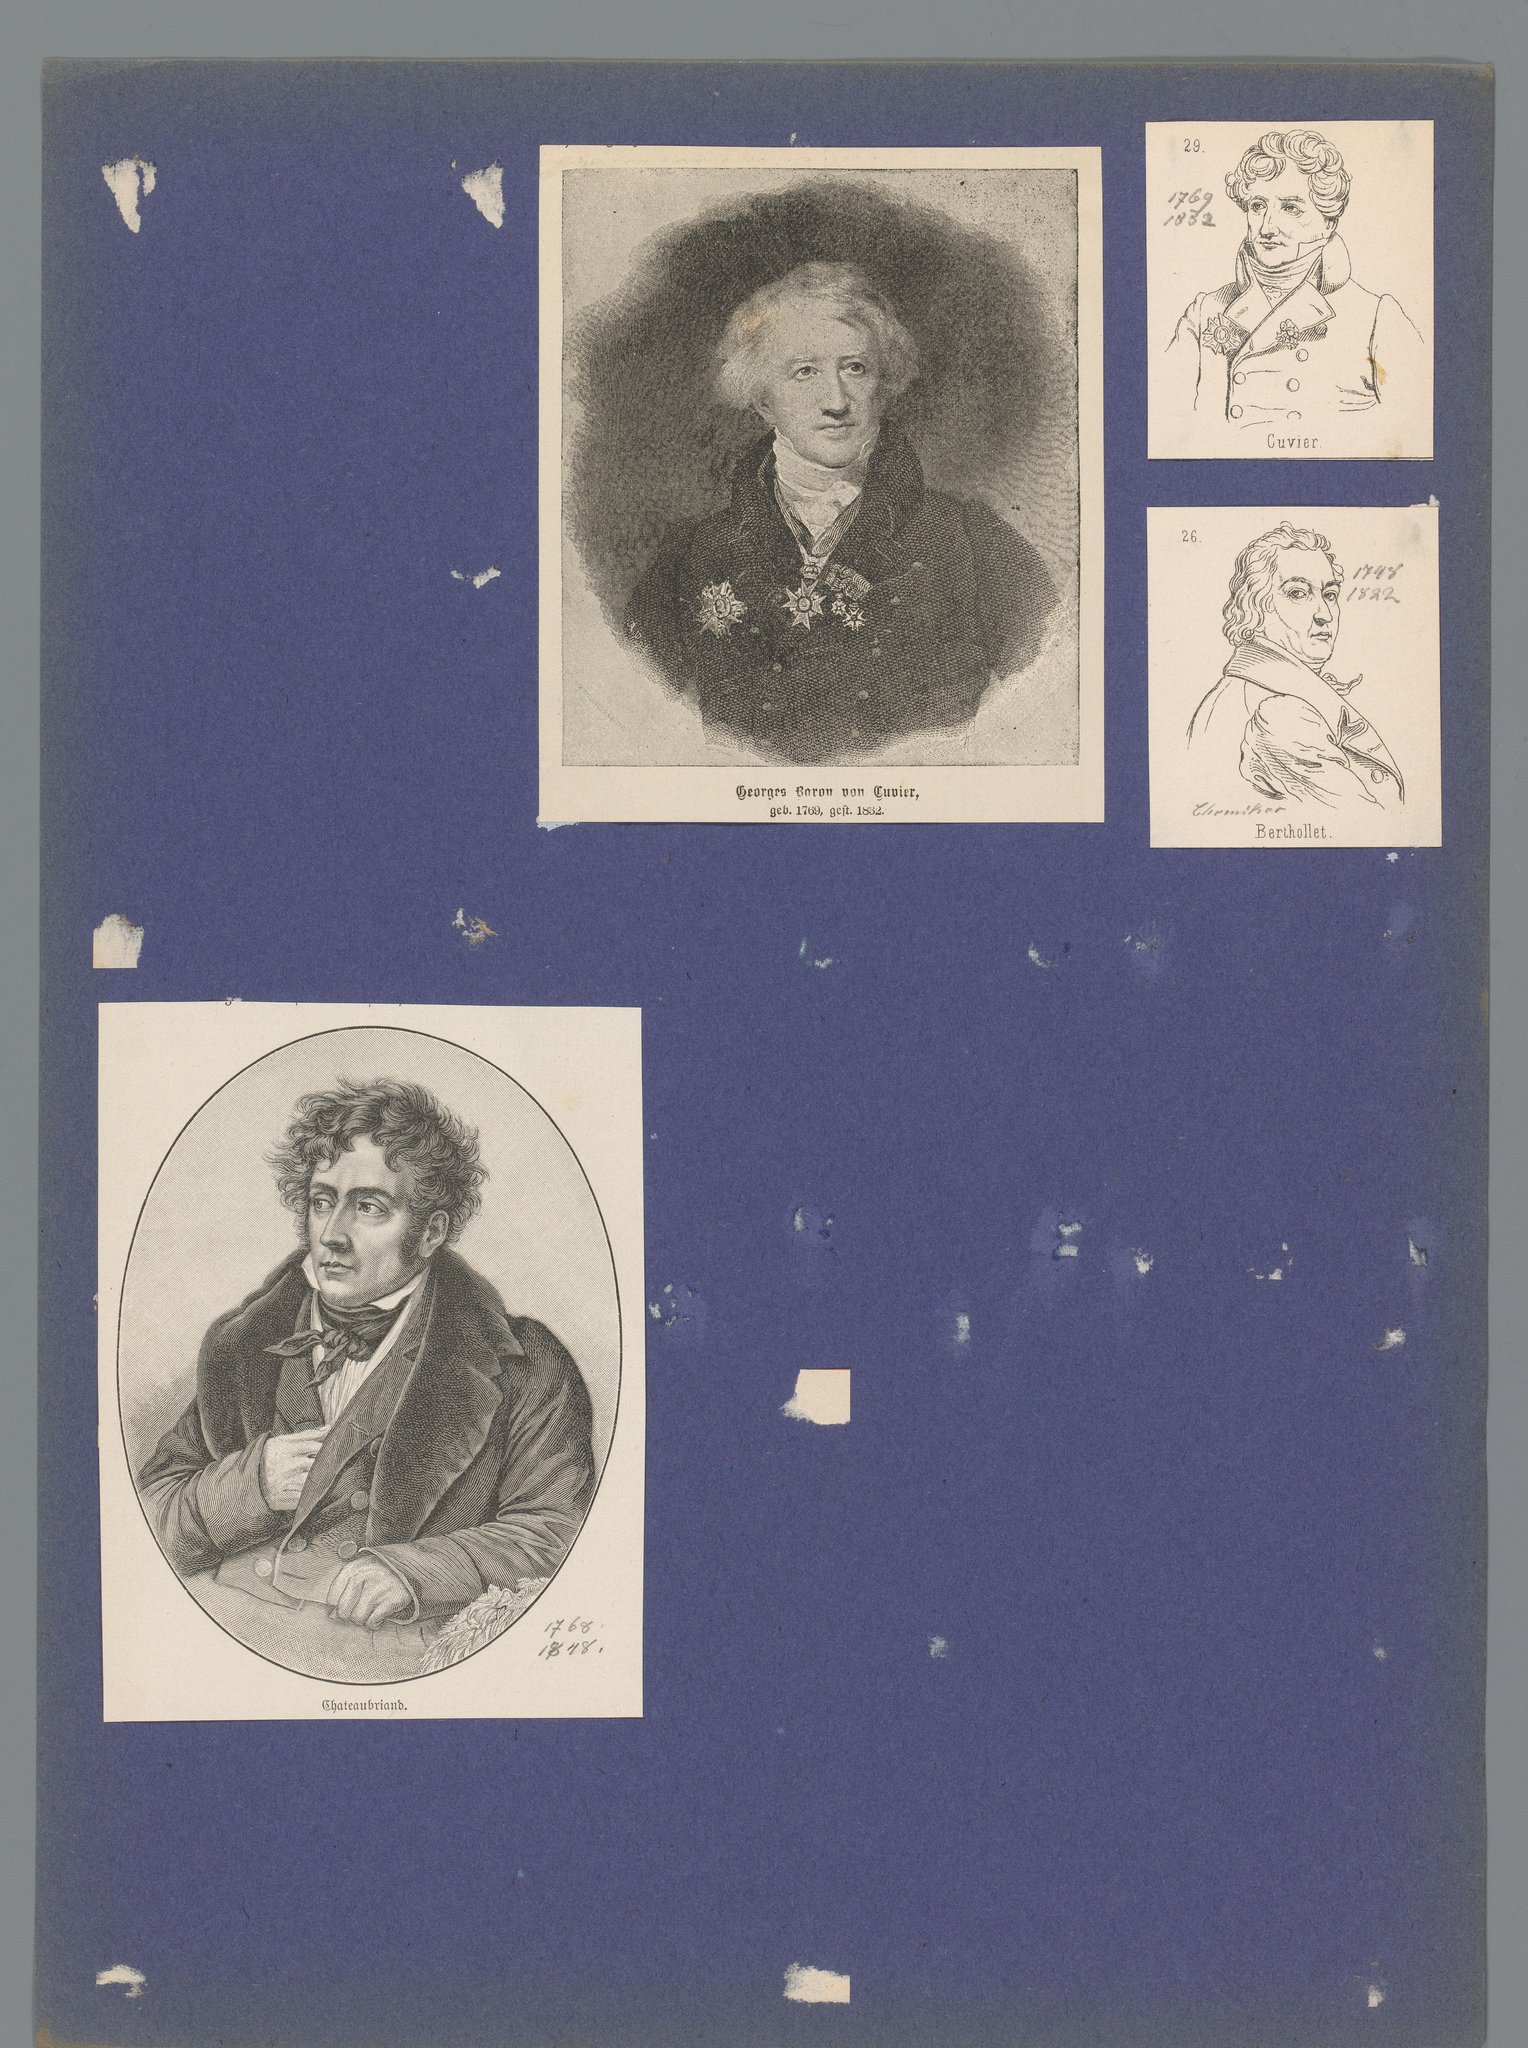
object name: print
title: Blad met twee portretten van Georges Cuvier, één van Claude-Louis, graaf van Berthollet en één van François-René de Chateaubriand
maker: Anonymous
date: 1850-1900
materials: paper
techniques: snipping, engraving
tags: paris, politician, françois-rené de chateaubriand, historical persons, physician, doctor (+ portrait of scholar, scientist), scholar, philosopher (+ portrait of scholar, scientist)